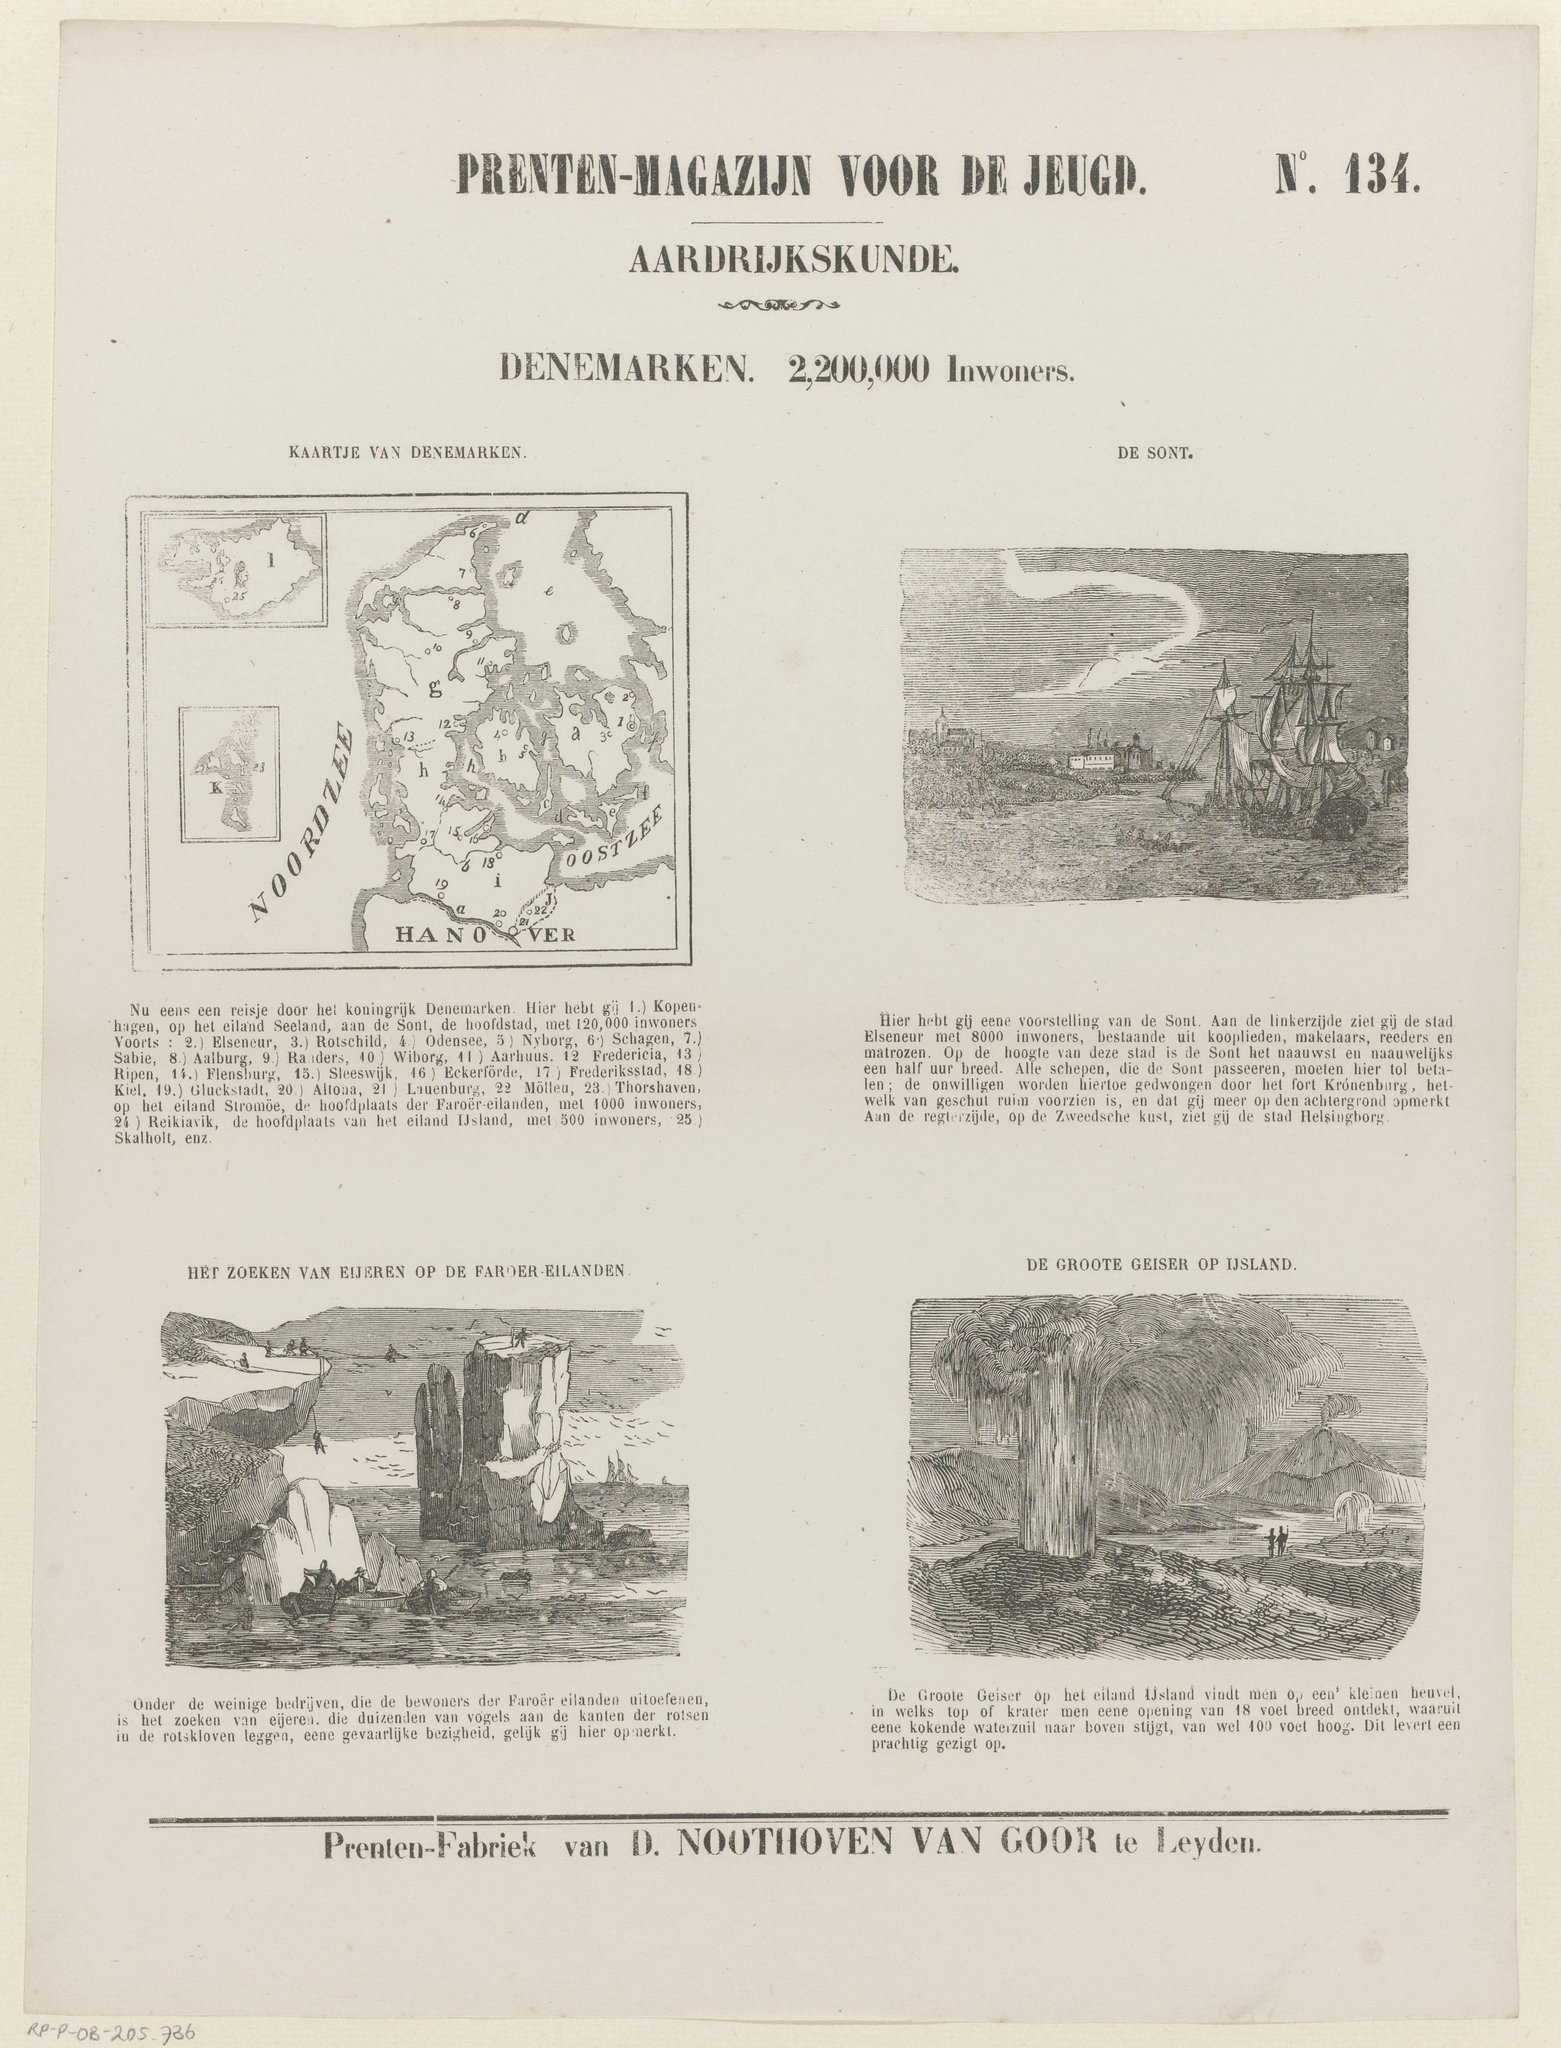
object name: print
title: Denemarken. 2,200,000 inwoners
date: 1850-1881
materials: paper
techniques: letterpress printing, engraving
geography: netherlands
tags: hot spring, geyser, maps, atlases, denmark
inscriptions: collector's mark: Lugt 2760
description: Blad met 4 voorstellingen over Denemarken en IJsland met een kaart en belangrijke plaatsen: de Sont, de Faeröer en de grote geiser op IJsland. Boven elke voorstelling een titel en onder elke voorstelling een onderschrift. Genummerd rechtsboven: No. 134.